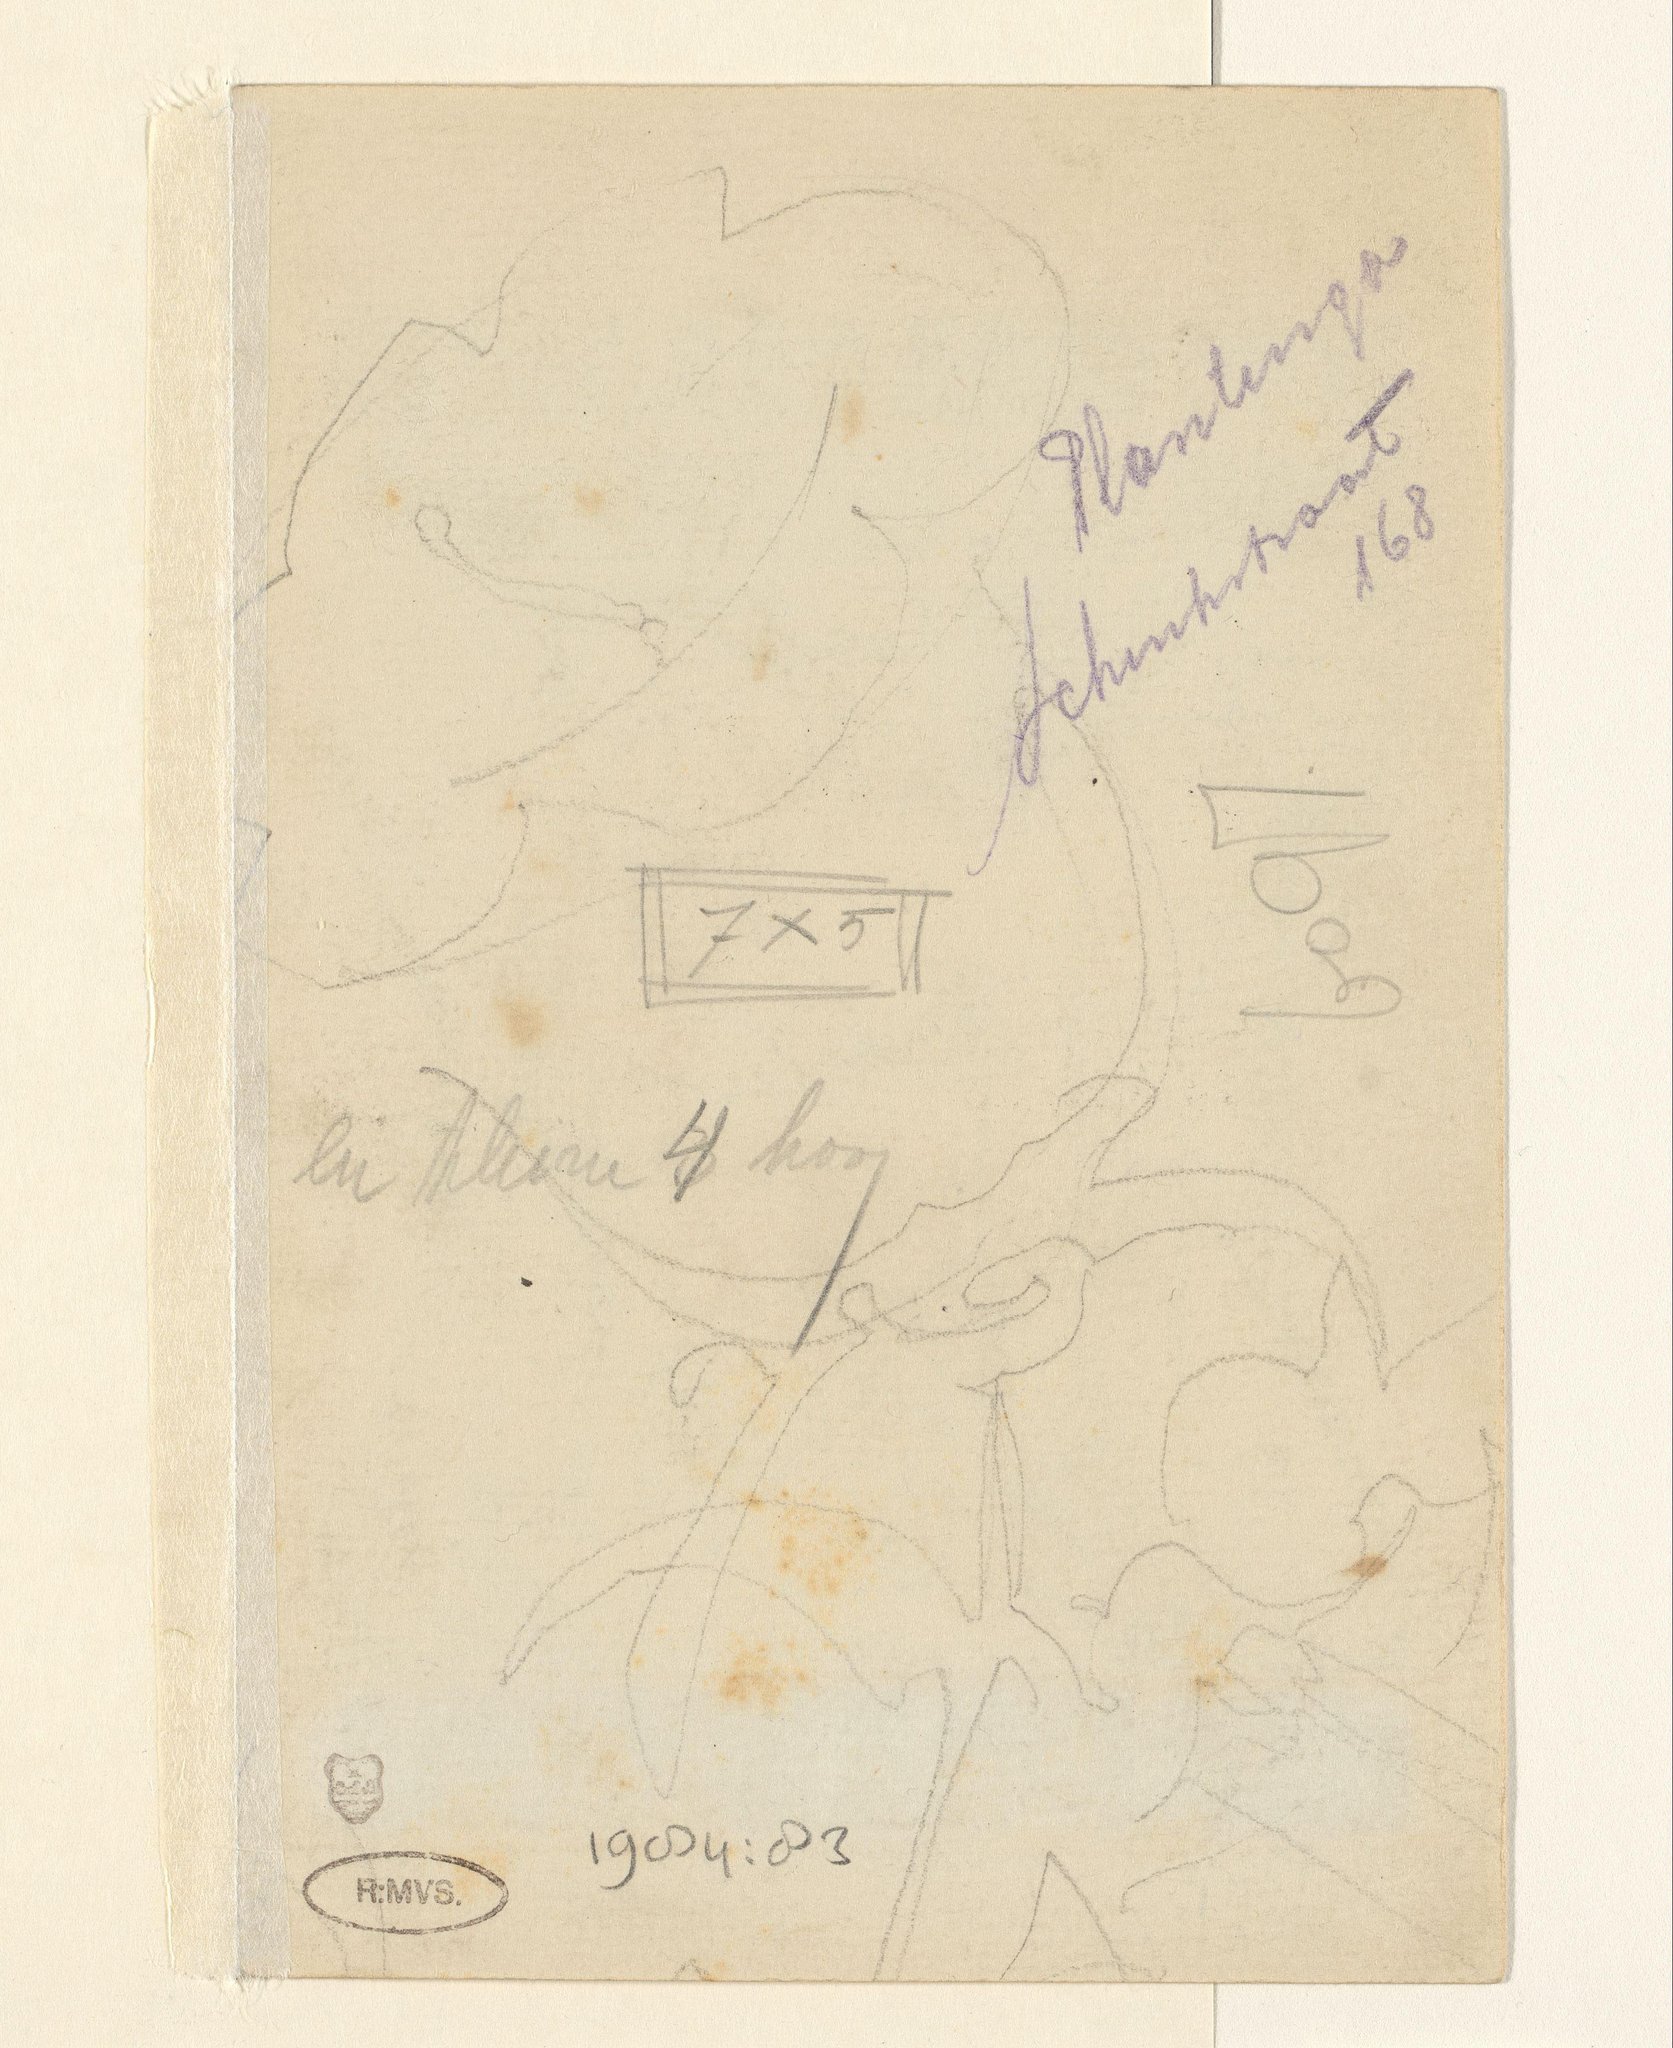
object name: drawing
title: Bloem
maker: reijer stolk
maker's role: draughtsman, print maker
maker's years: 1896-1945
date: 1906-1945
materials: paper, pencil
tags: flowers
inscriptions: collector's mark: Lugt 2228, collector's mark: Lugt 2760, :, inscription: ‘Plantenga (...)’